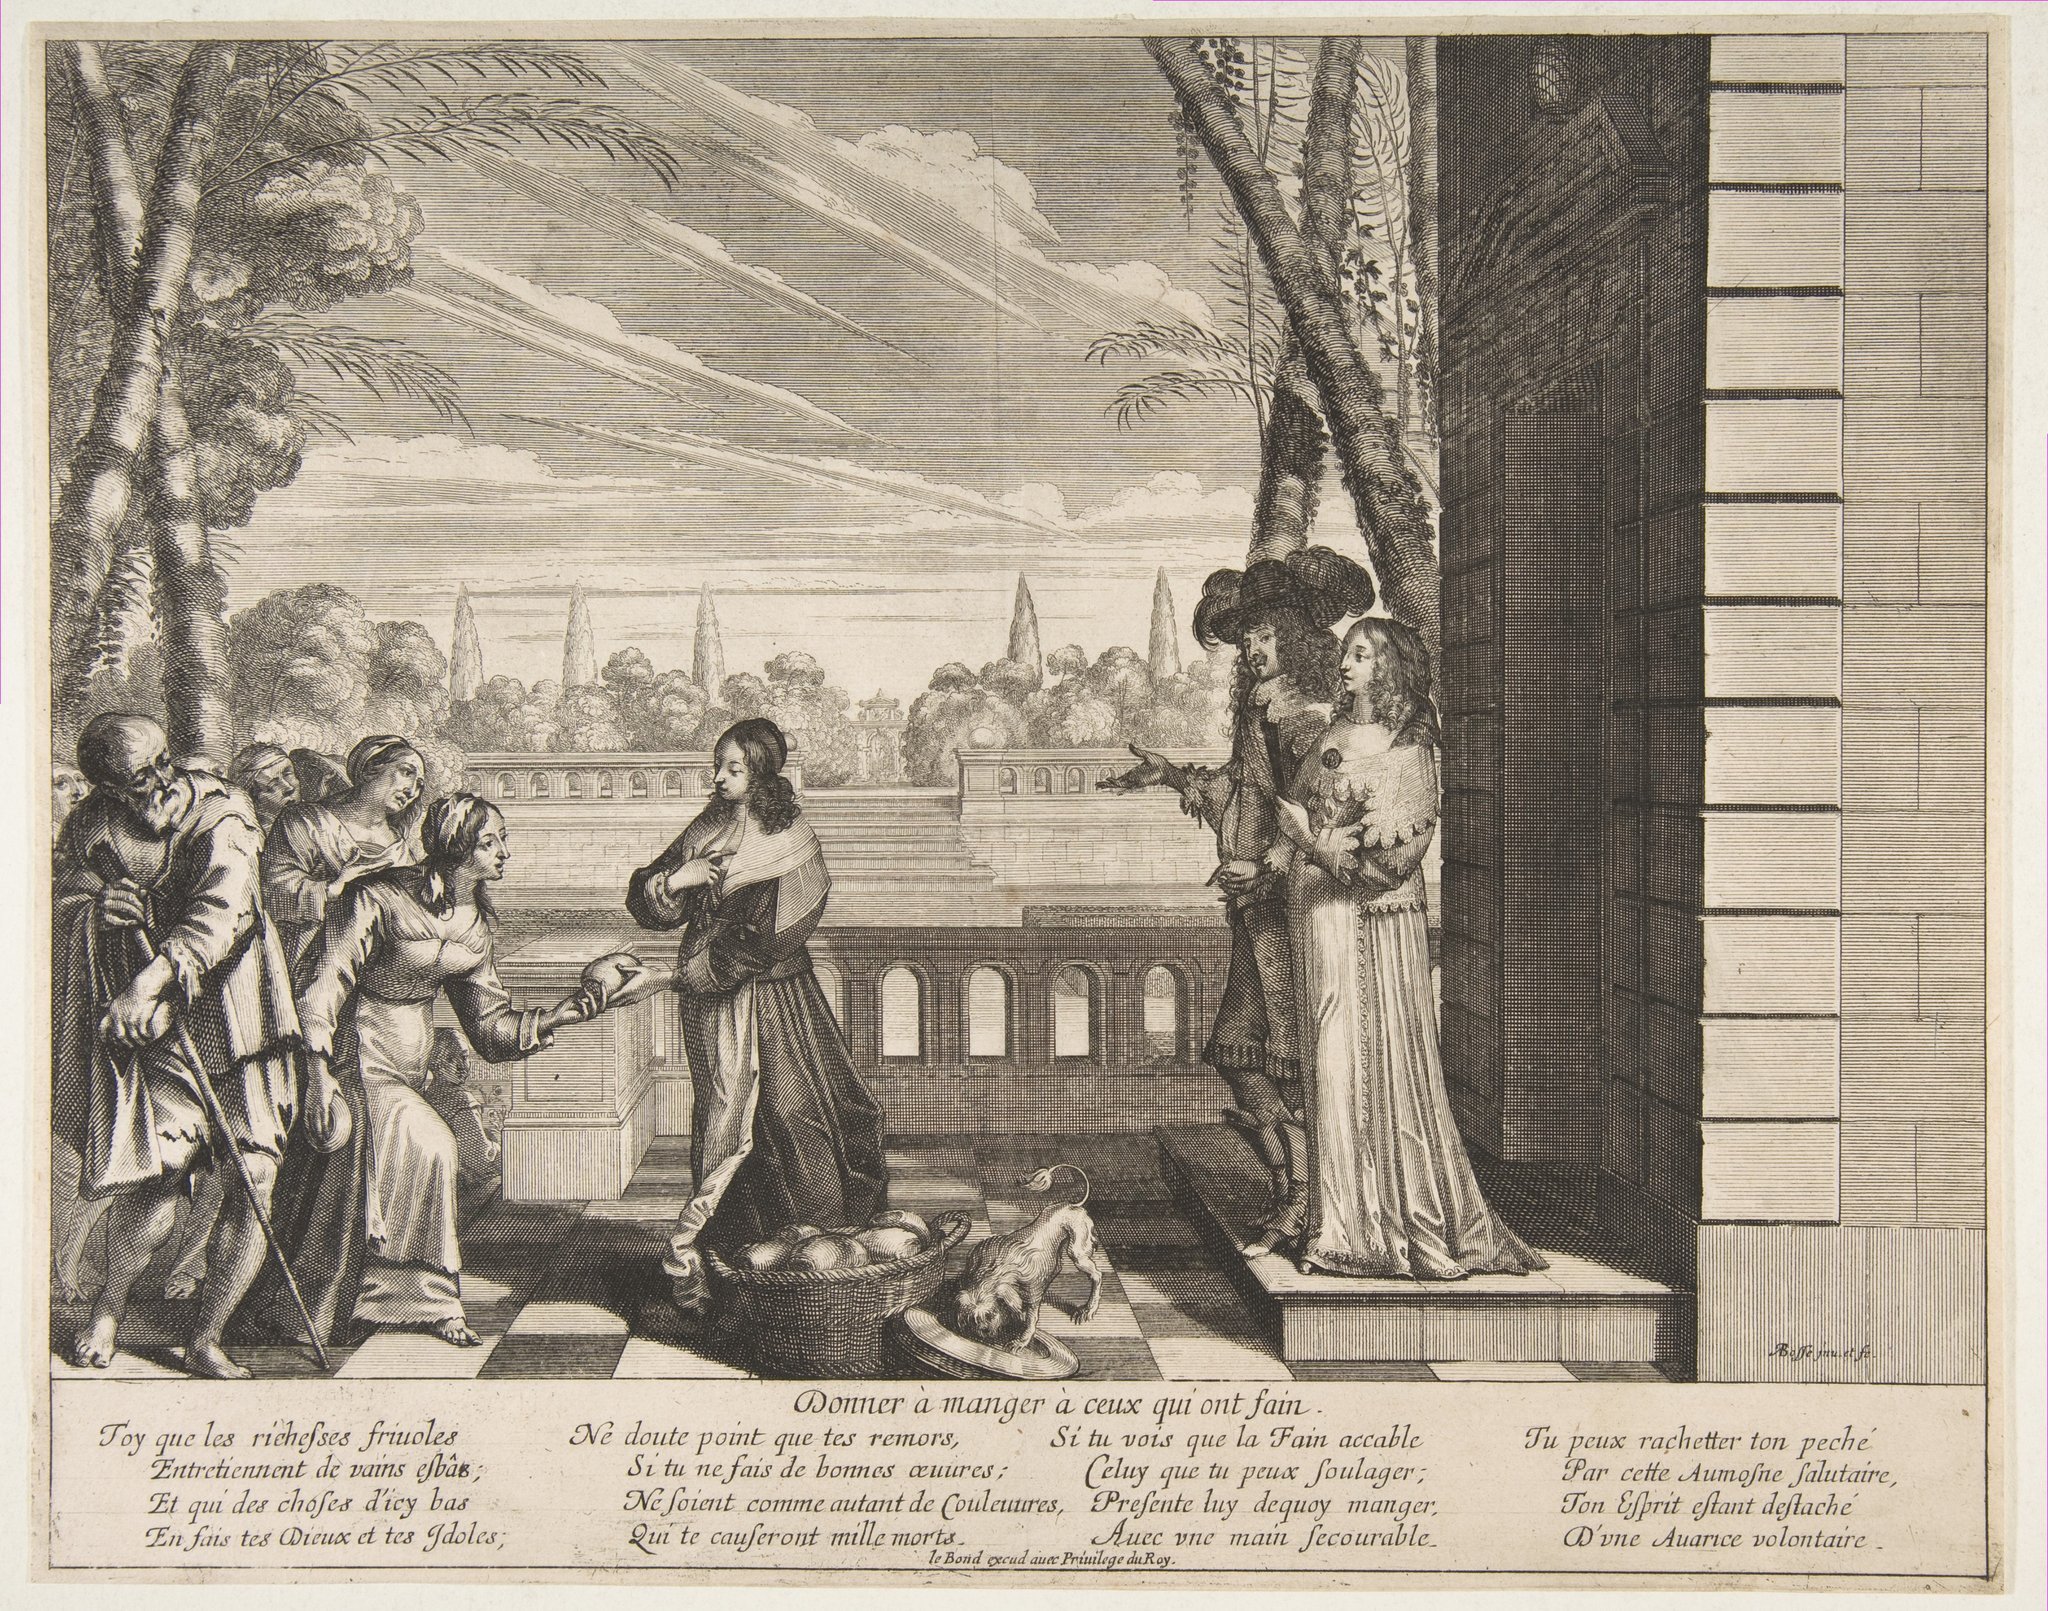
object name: print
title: Feeding the Hungry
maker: abraham bosse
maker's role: artist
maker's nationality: french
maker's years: 1602-1676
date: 1635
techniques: engraving, etching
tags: food,animals,bread,men,women,dogs,baskets